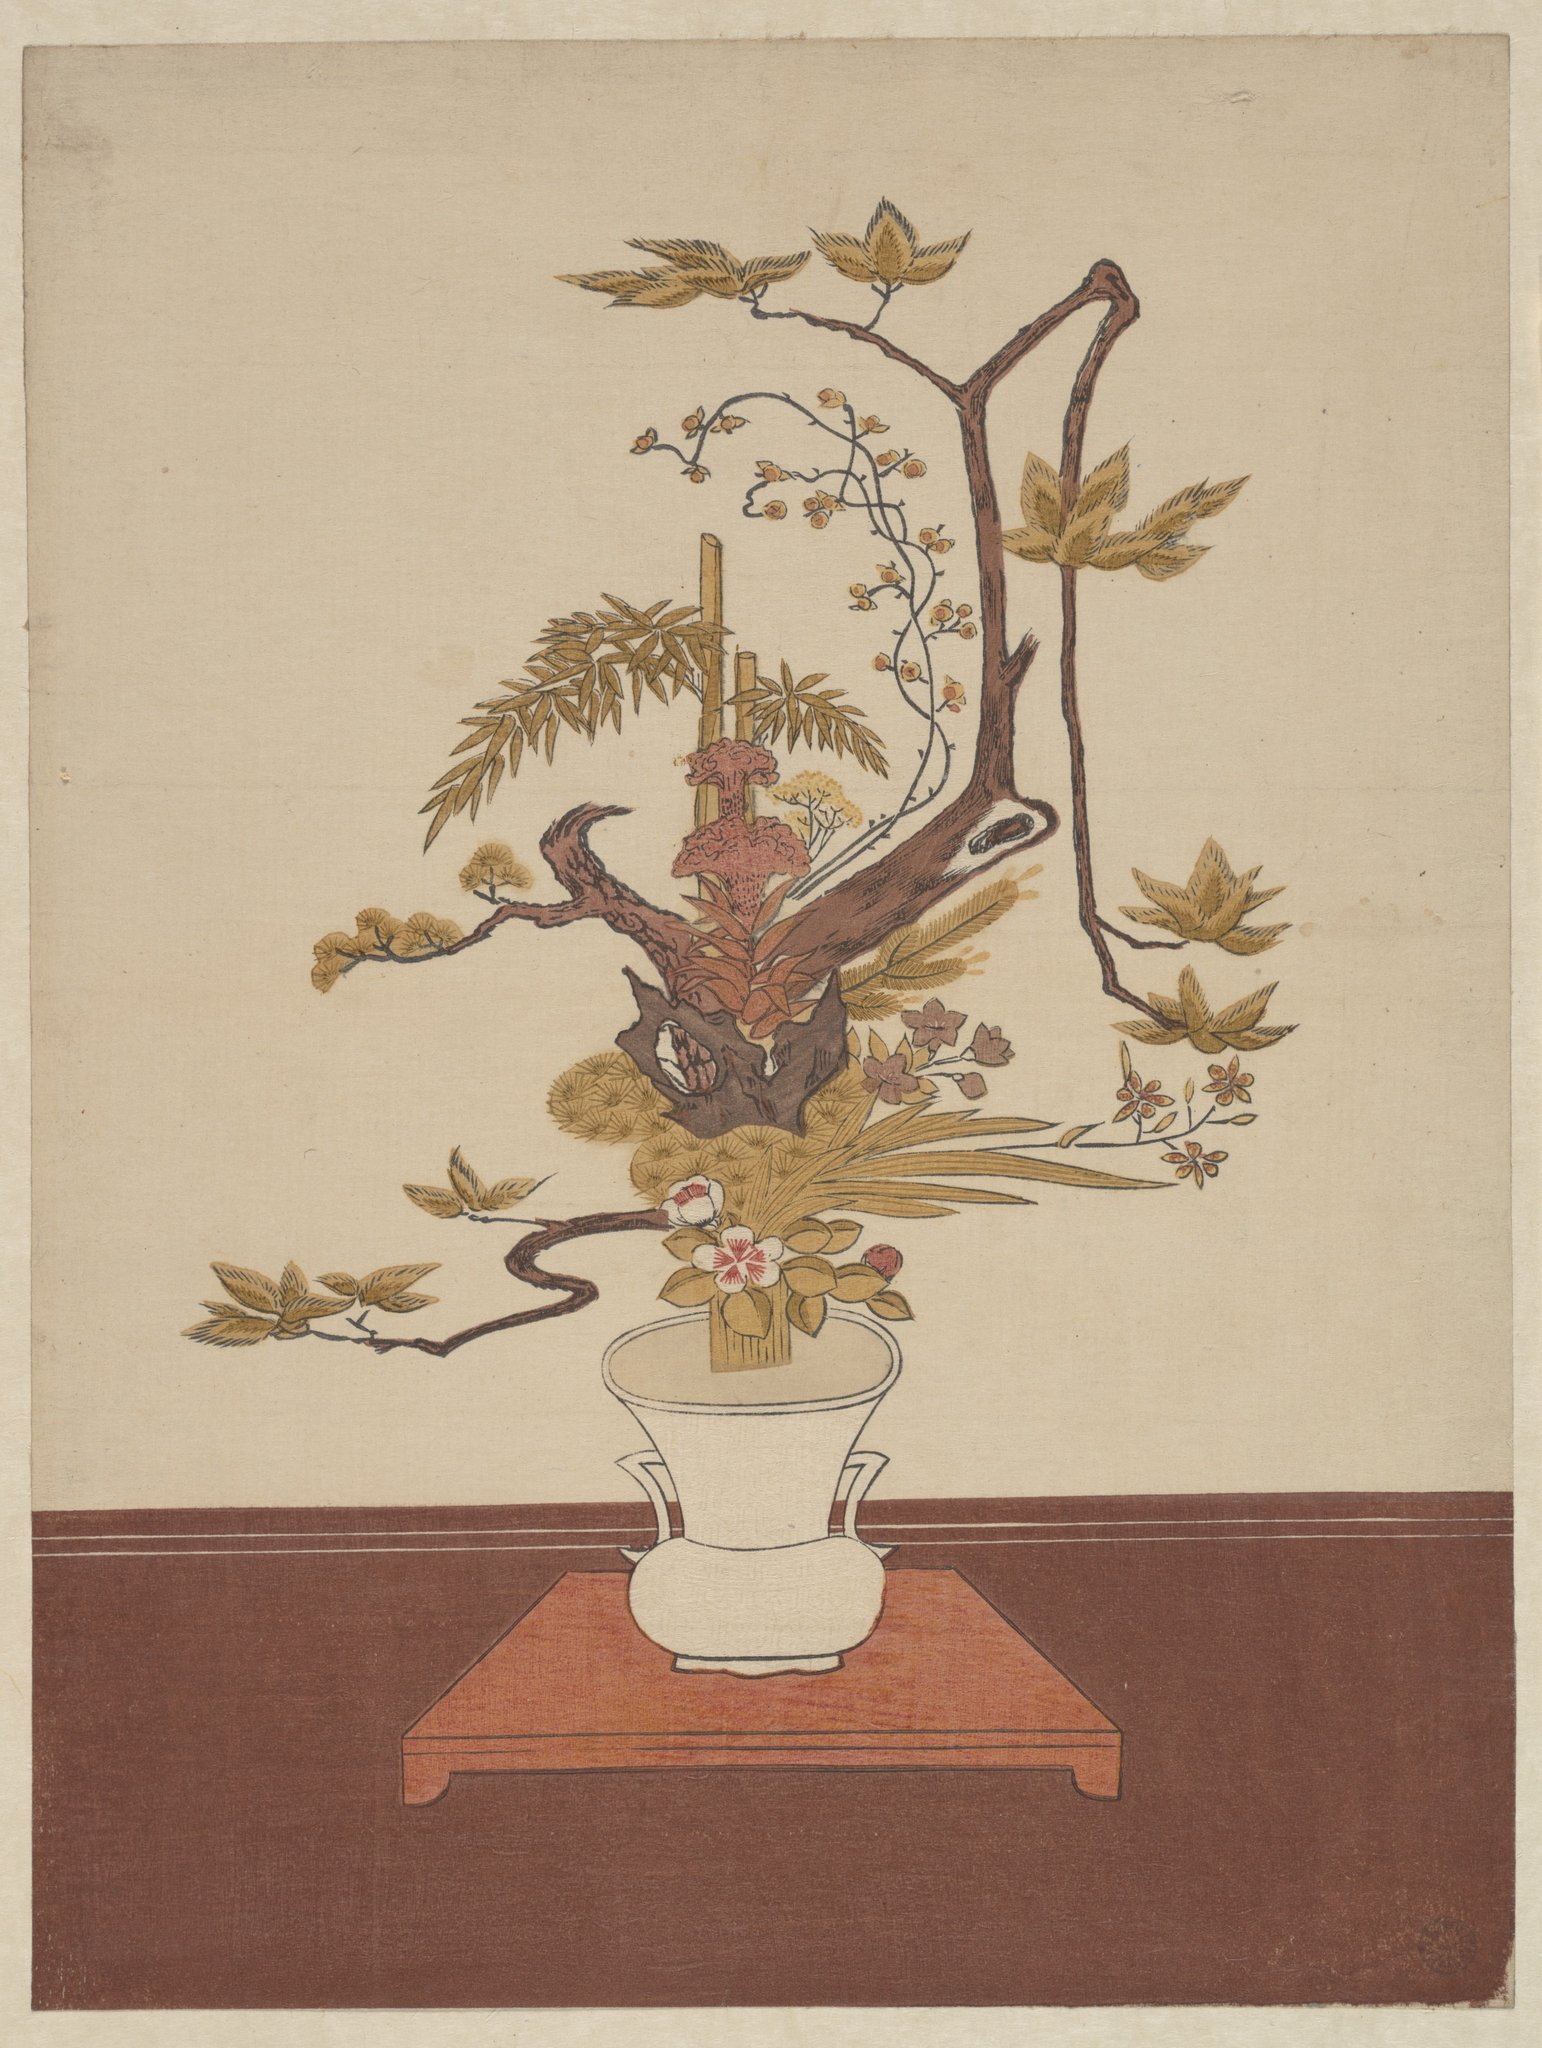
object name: print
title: Ike Bana (Flower Arrangement) in the Ike-no-bo Style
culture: japanese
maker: suzuki harunobu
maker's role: artist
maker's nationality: japanese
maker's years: 1725-1770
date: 1765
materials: ink, paper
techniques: woodblock print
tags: flowers,plants